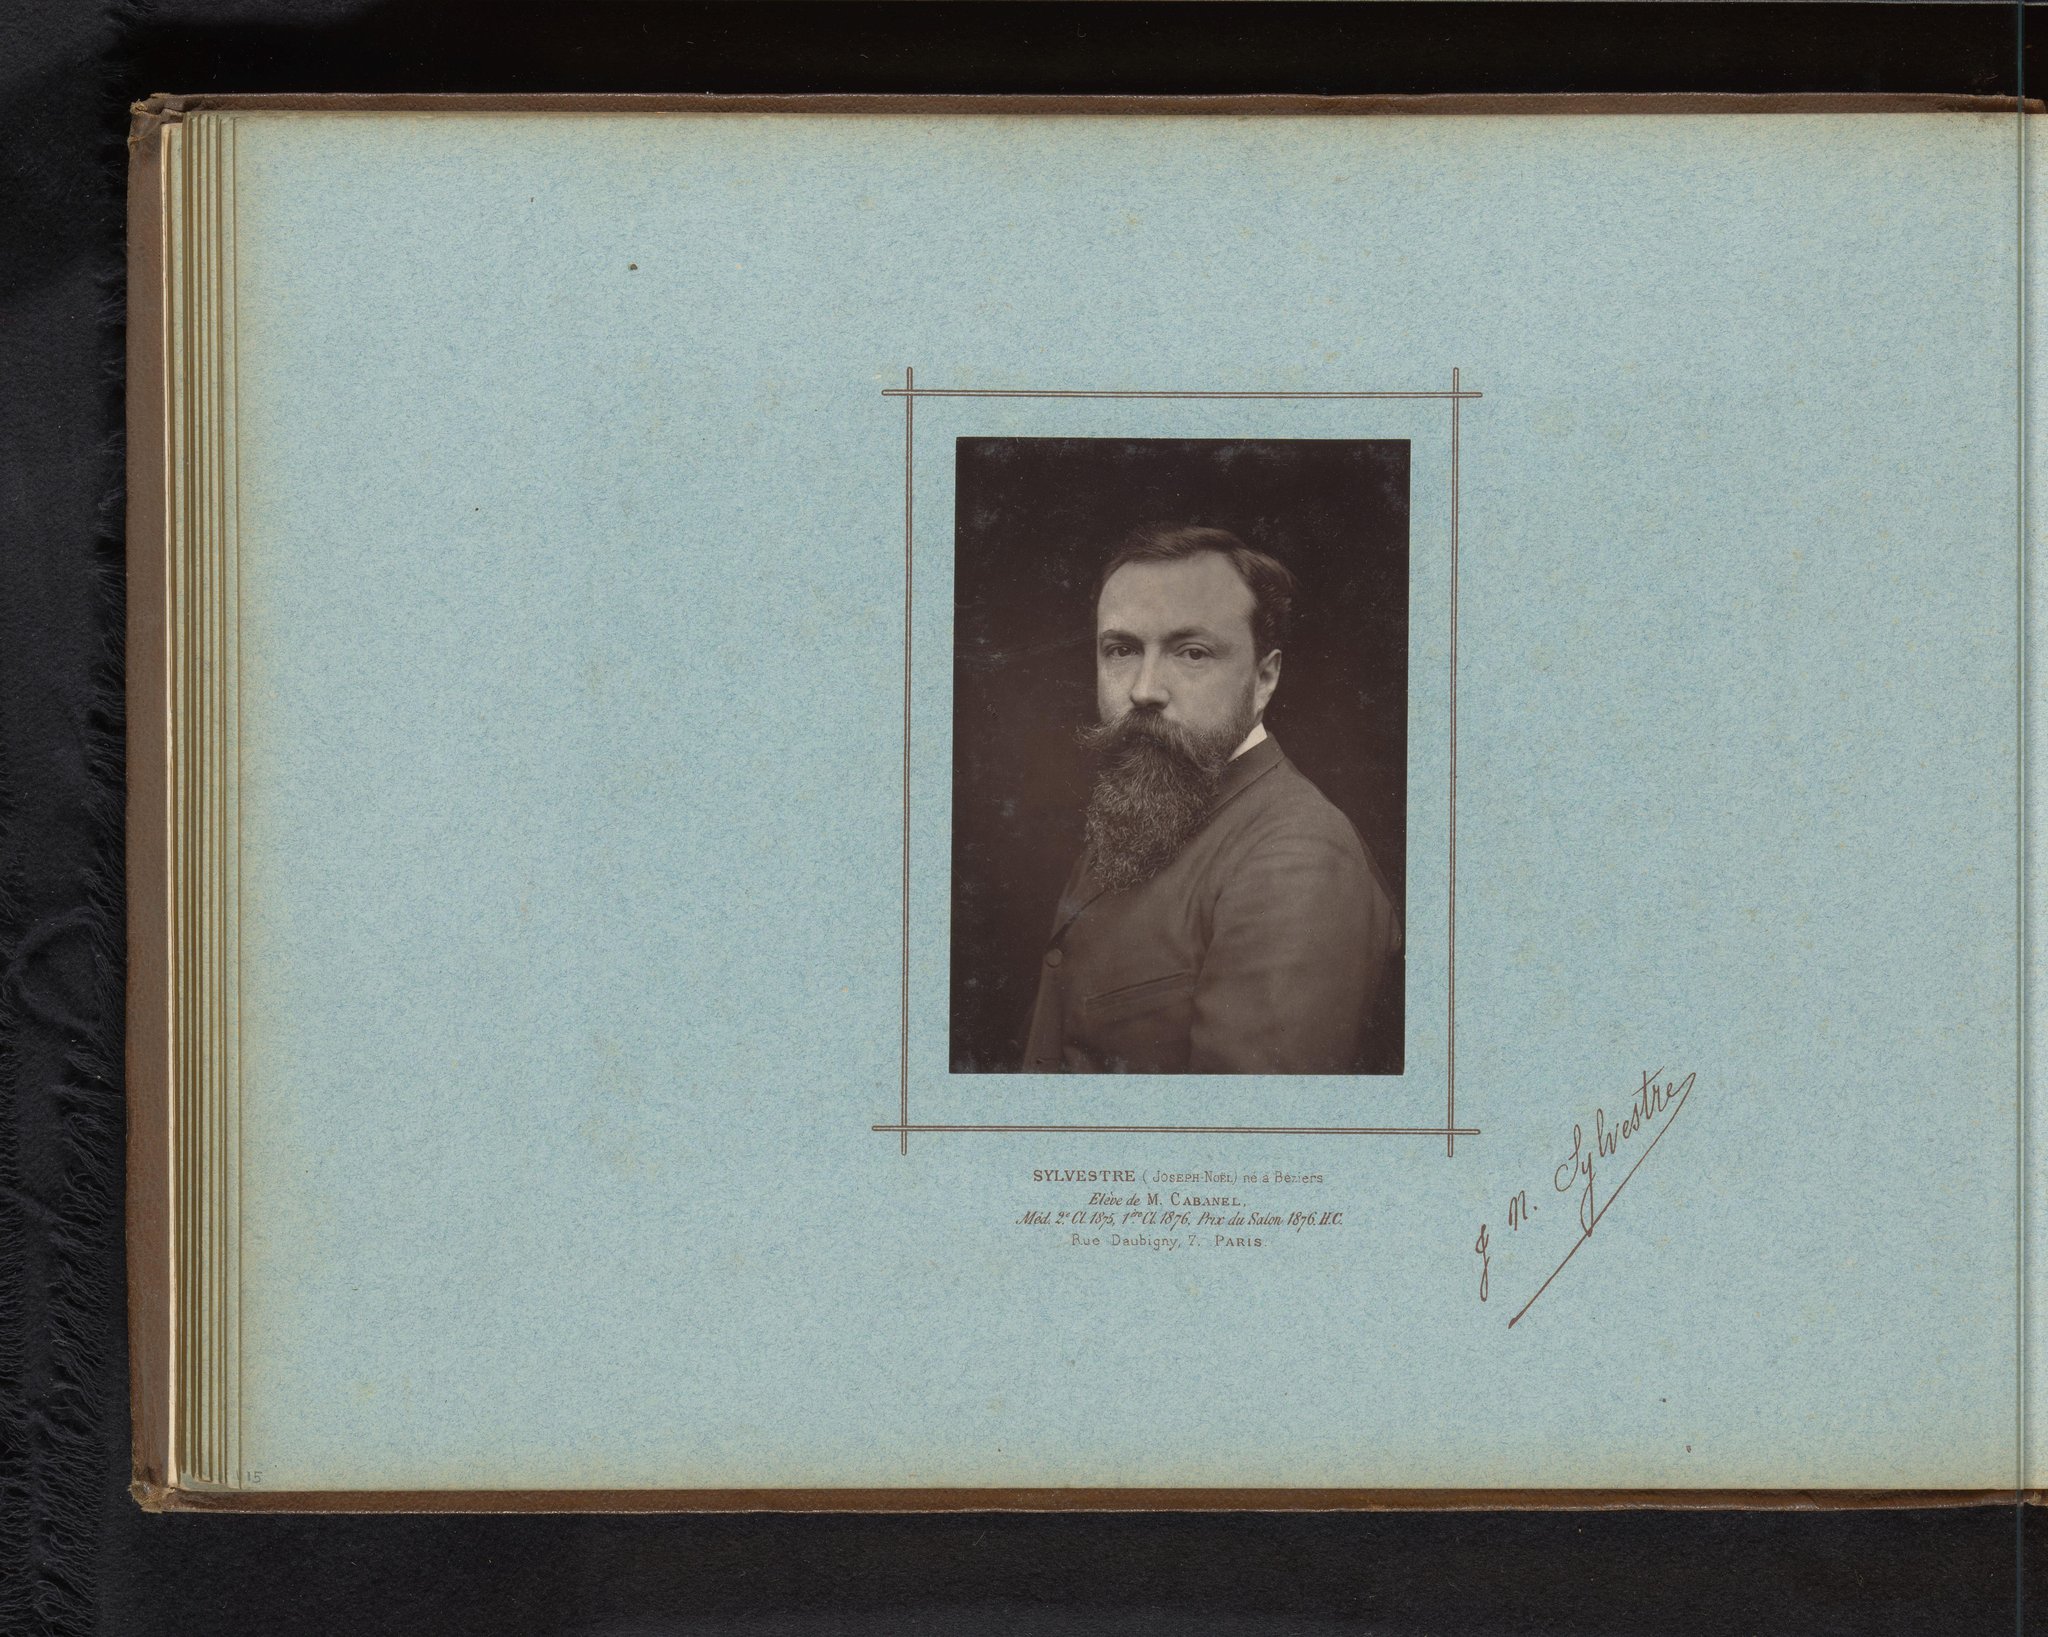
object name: photomechanical print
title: Portret van Joseph-Noël Sylvestre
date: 1879-1884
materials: paper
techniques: woodburytype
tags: paris, painter, joseph-noël sylvestre, historical persons, portrait, self-portrait of painter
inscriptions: inscription: ‘SYLVESTRE (Joseph-Noël) né à Beziers/ Elève de M. Cabanel./ Méd. 2e. Cl. 1875, 1ère. Cl. 1876, Prix du Salon, 1876. H.C./ Rue Daubigny, 7, Paris’, signature: ‘J. N. Sylvestre’